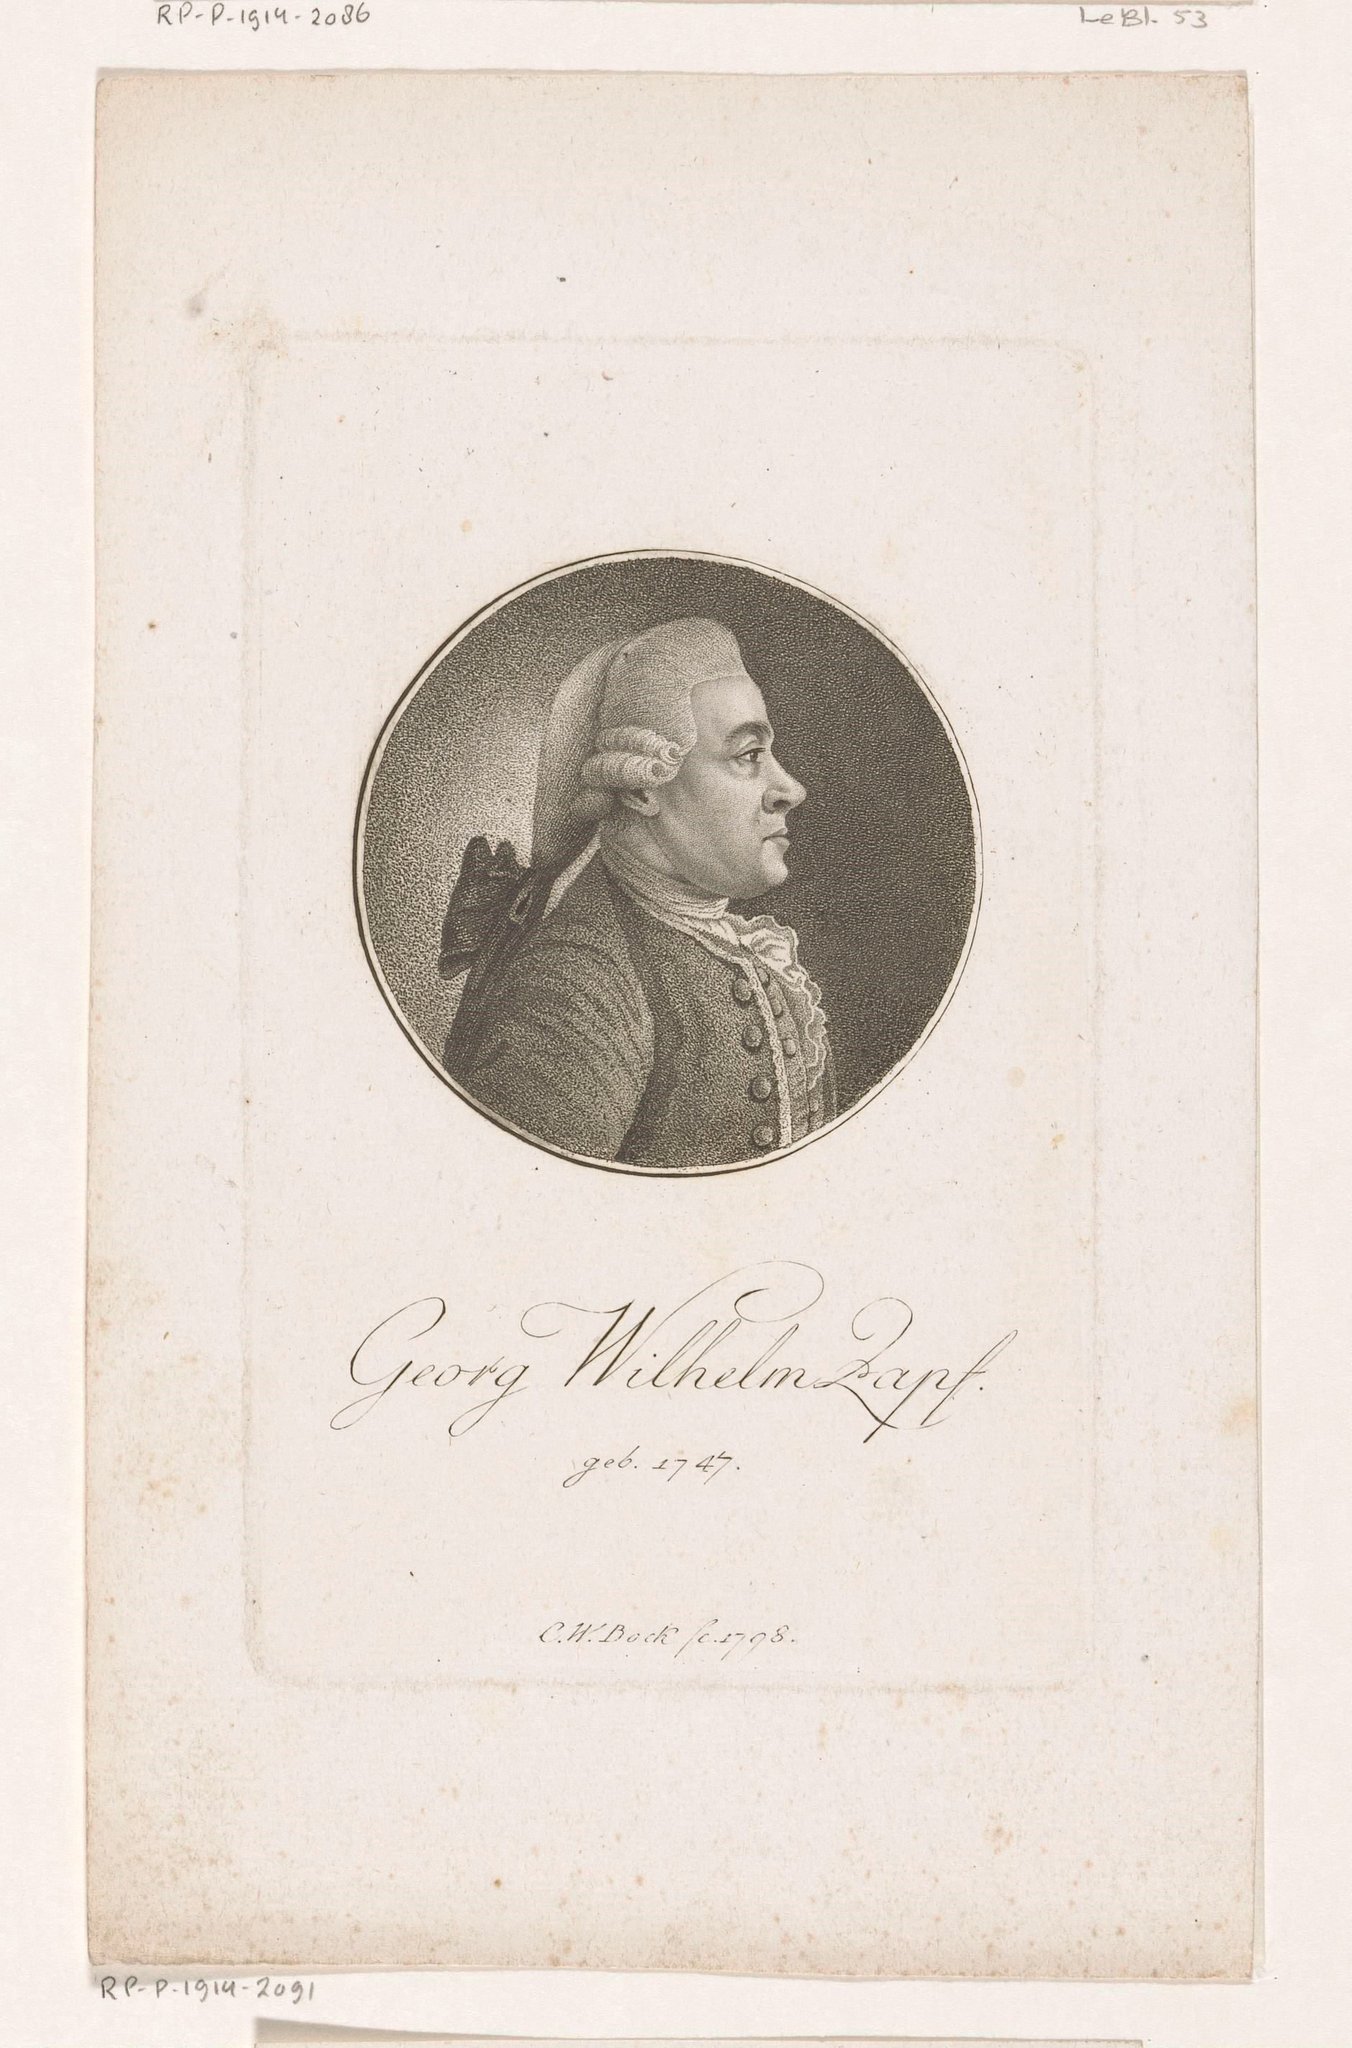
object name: print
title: Portret van Georg Wilhelm Zapf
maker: christoph wilhelm bock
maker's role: print maker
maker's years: 1755-1836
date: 1798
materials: paper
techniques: etching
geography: nuremberg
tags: augsburg, historical persons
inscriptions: collector's mark: Lugt 2228